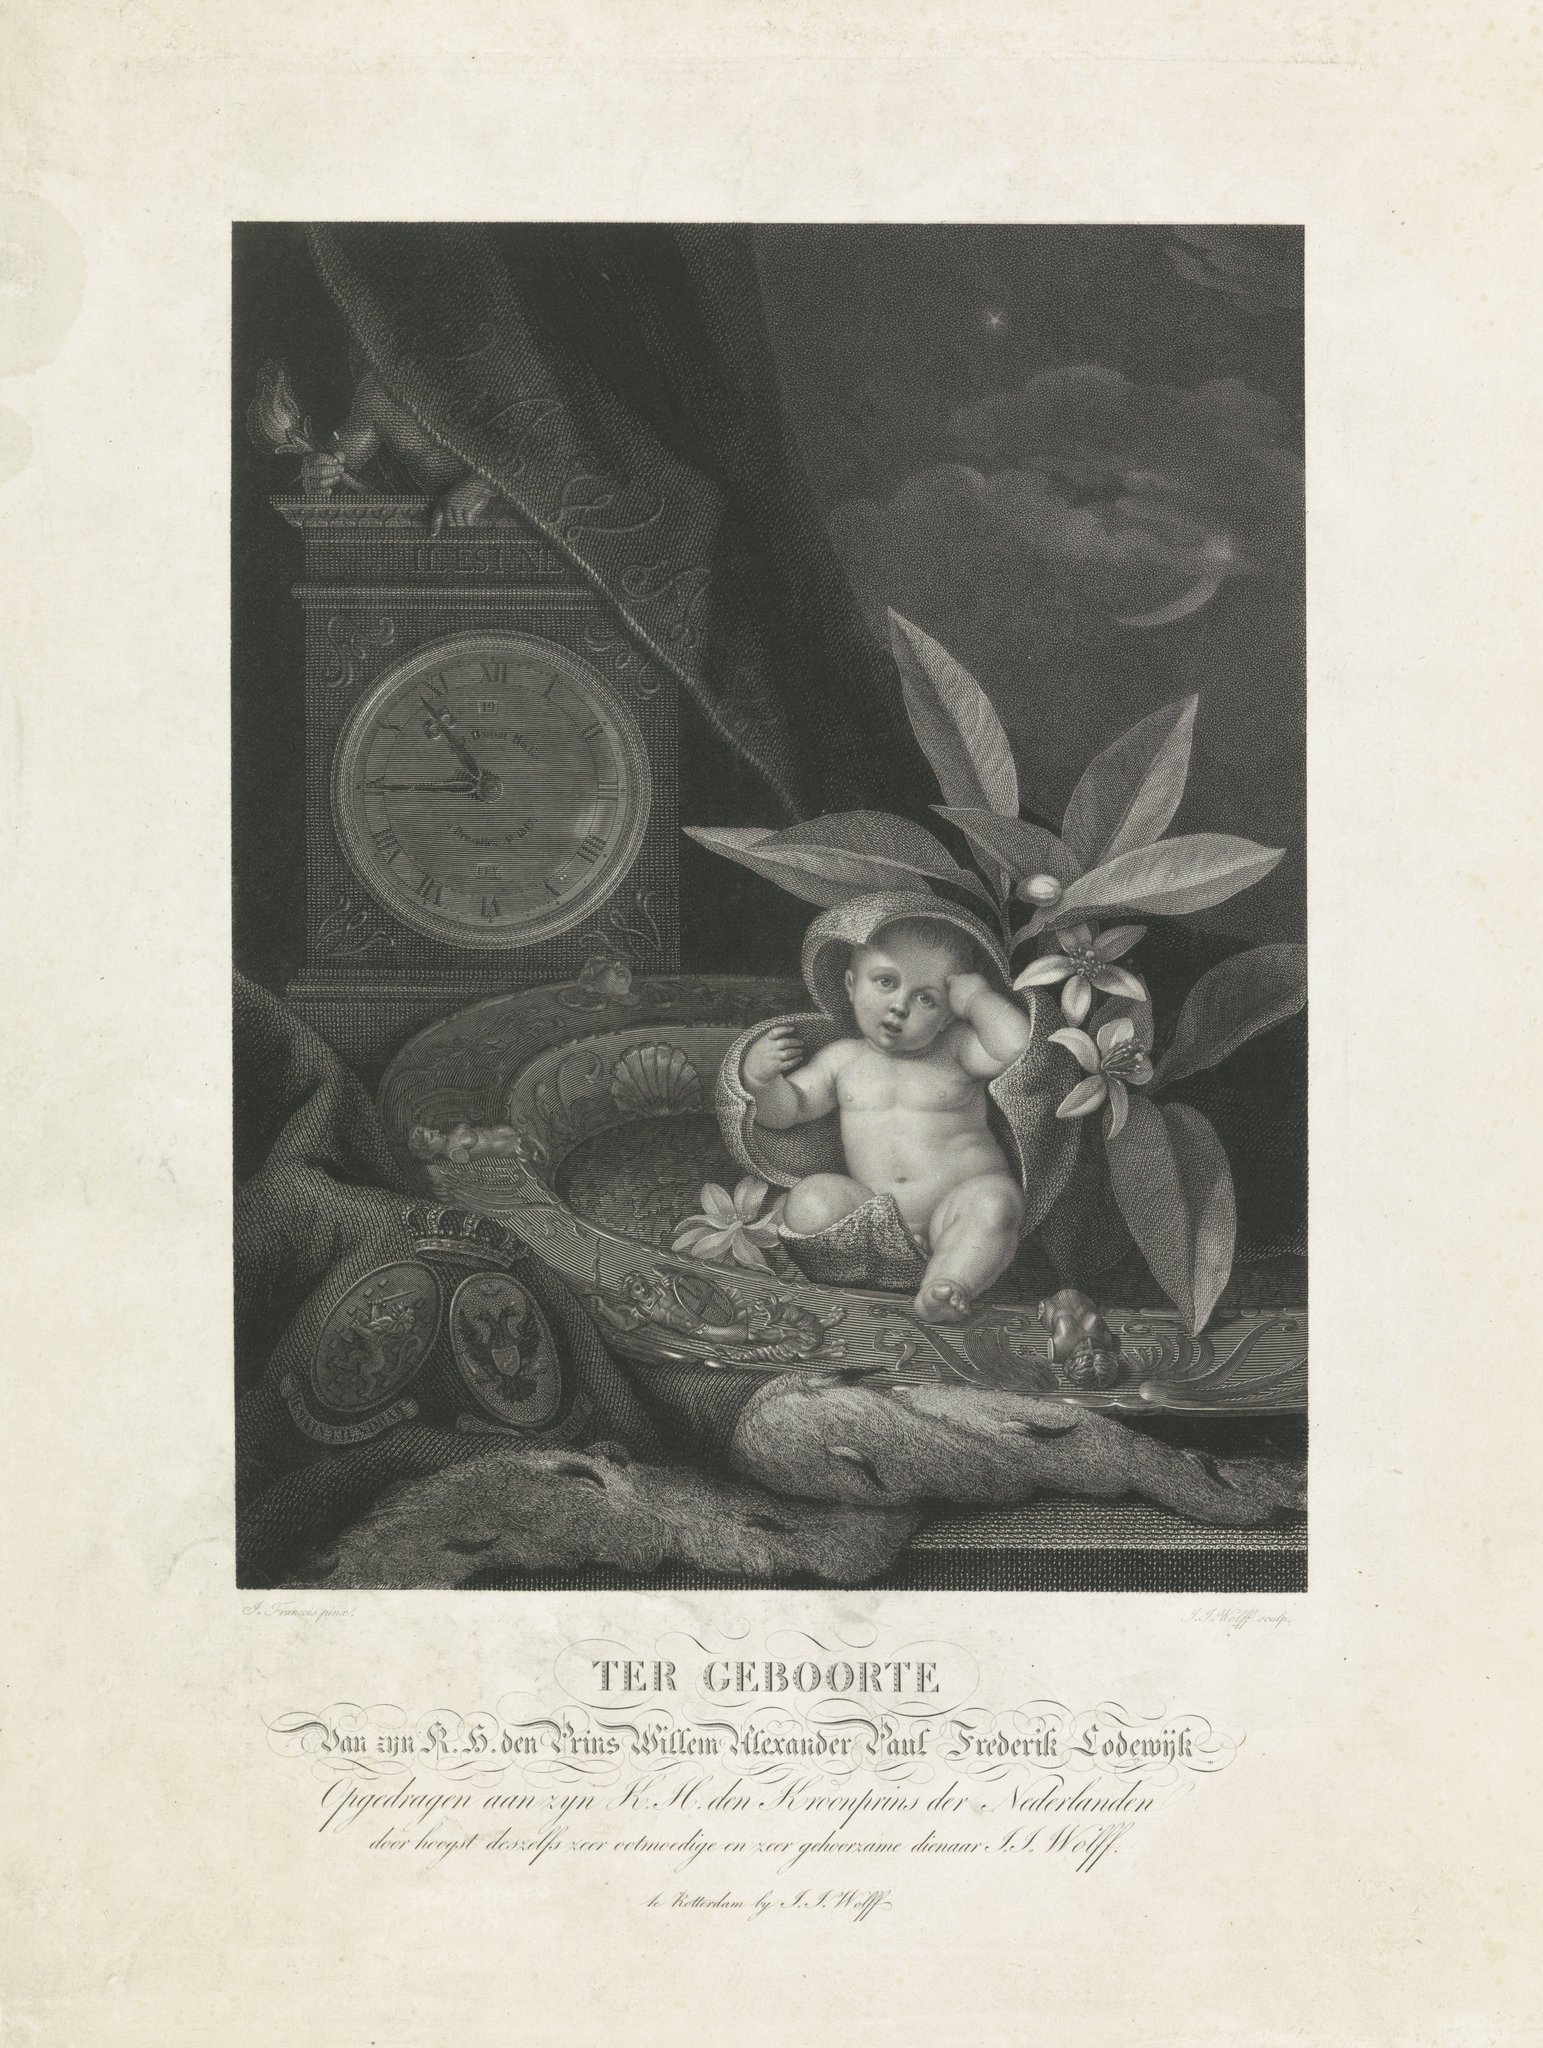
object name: print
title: Ter geboorte van zijne K.H. den Prins Willem Alexander Paul Frederik Lodewijk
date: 1817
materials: paper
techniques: engraving, etching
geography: rotterdam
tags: brussels, willem iii (koning der nederlanden), pretended places where the babies grow, infant, baby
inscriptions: collector's mark: Lugt Lugt 2228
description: Allegorie op de geboorte van Willem Alexander Paul Frederik Lodewijk, de erfprins van Oranje en latere koning Willem III, op 19 februari 1817. Een kindje kruipt uit het opengebarsten omhulsel van een Oranjeappel, de vrucht van een sinaasappel. Hij ligt in een platte schaal versierd met symbolische figuren. Links op een kleed de wapens van Nederland en Rusland. Linksachter een klok met de tekst: Il est né. Op de achtergrond een nachtelijke hemel. Bij de prent behoort een afzonderlijke verklaring.